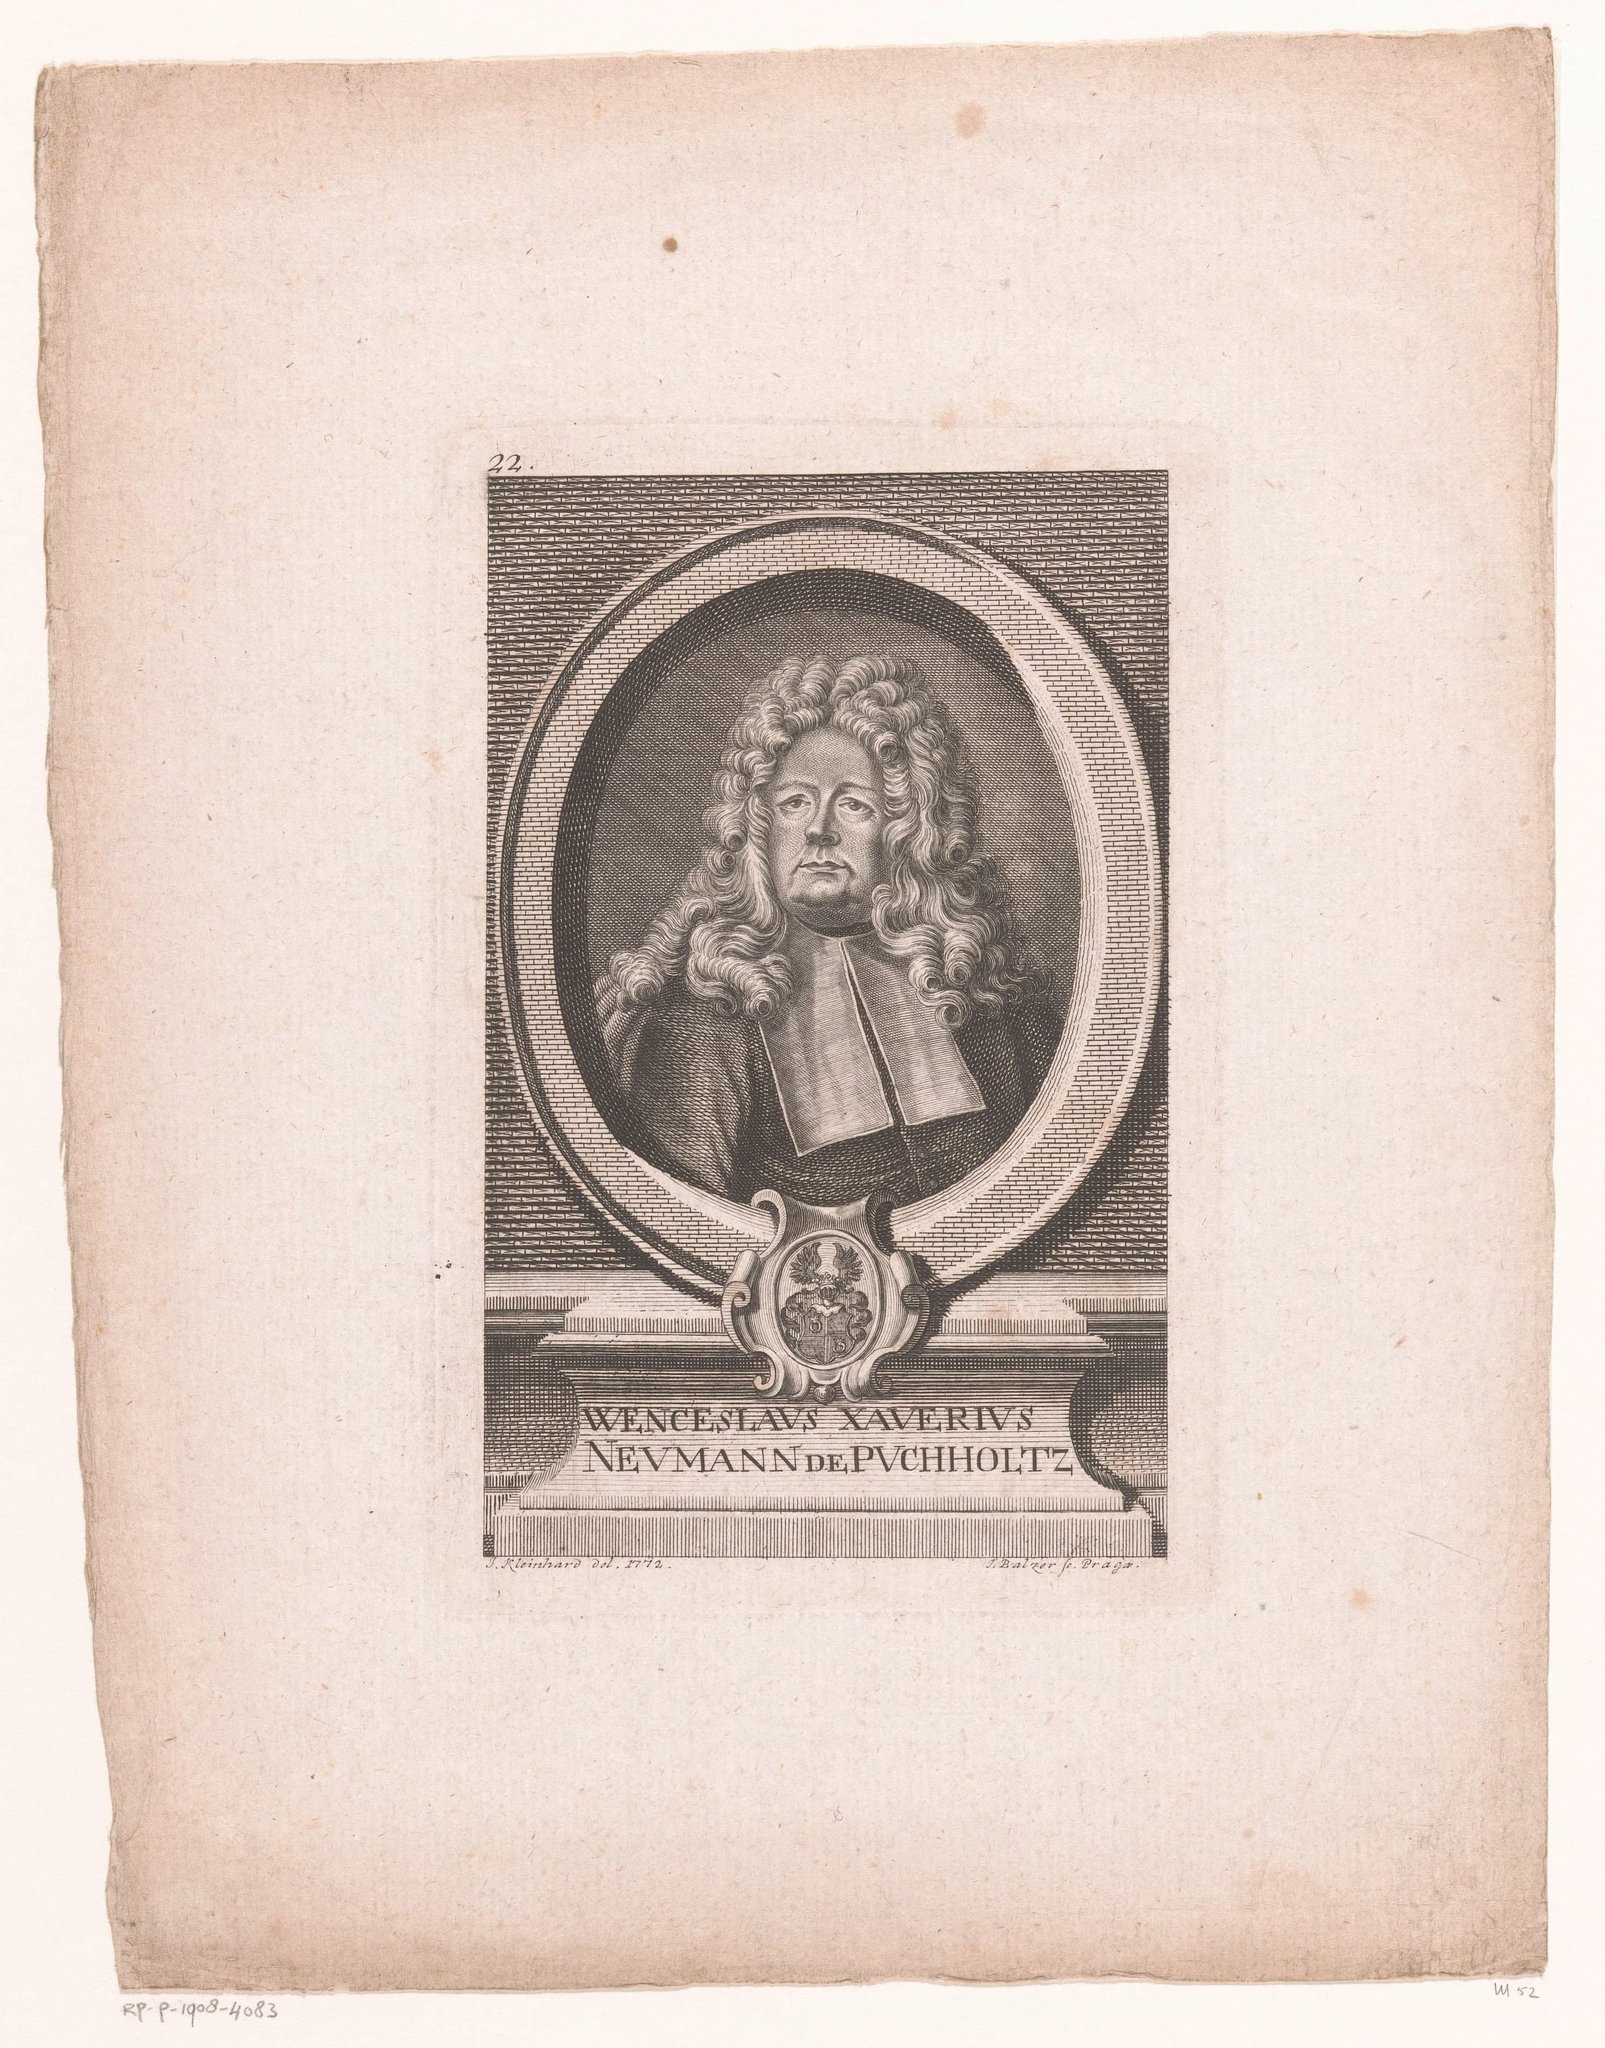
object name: print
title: Wenceslaus Xaverius Neumann de Puchholtz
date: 1772-1799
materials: paper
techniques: engraving, etching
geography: prague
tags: prague, historical persons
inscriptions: collector's mark: Lugt 2228